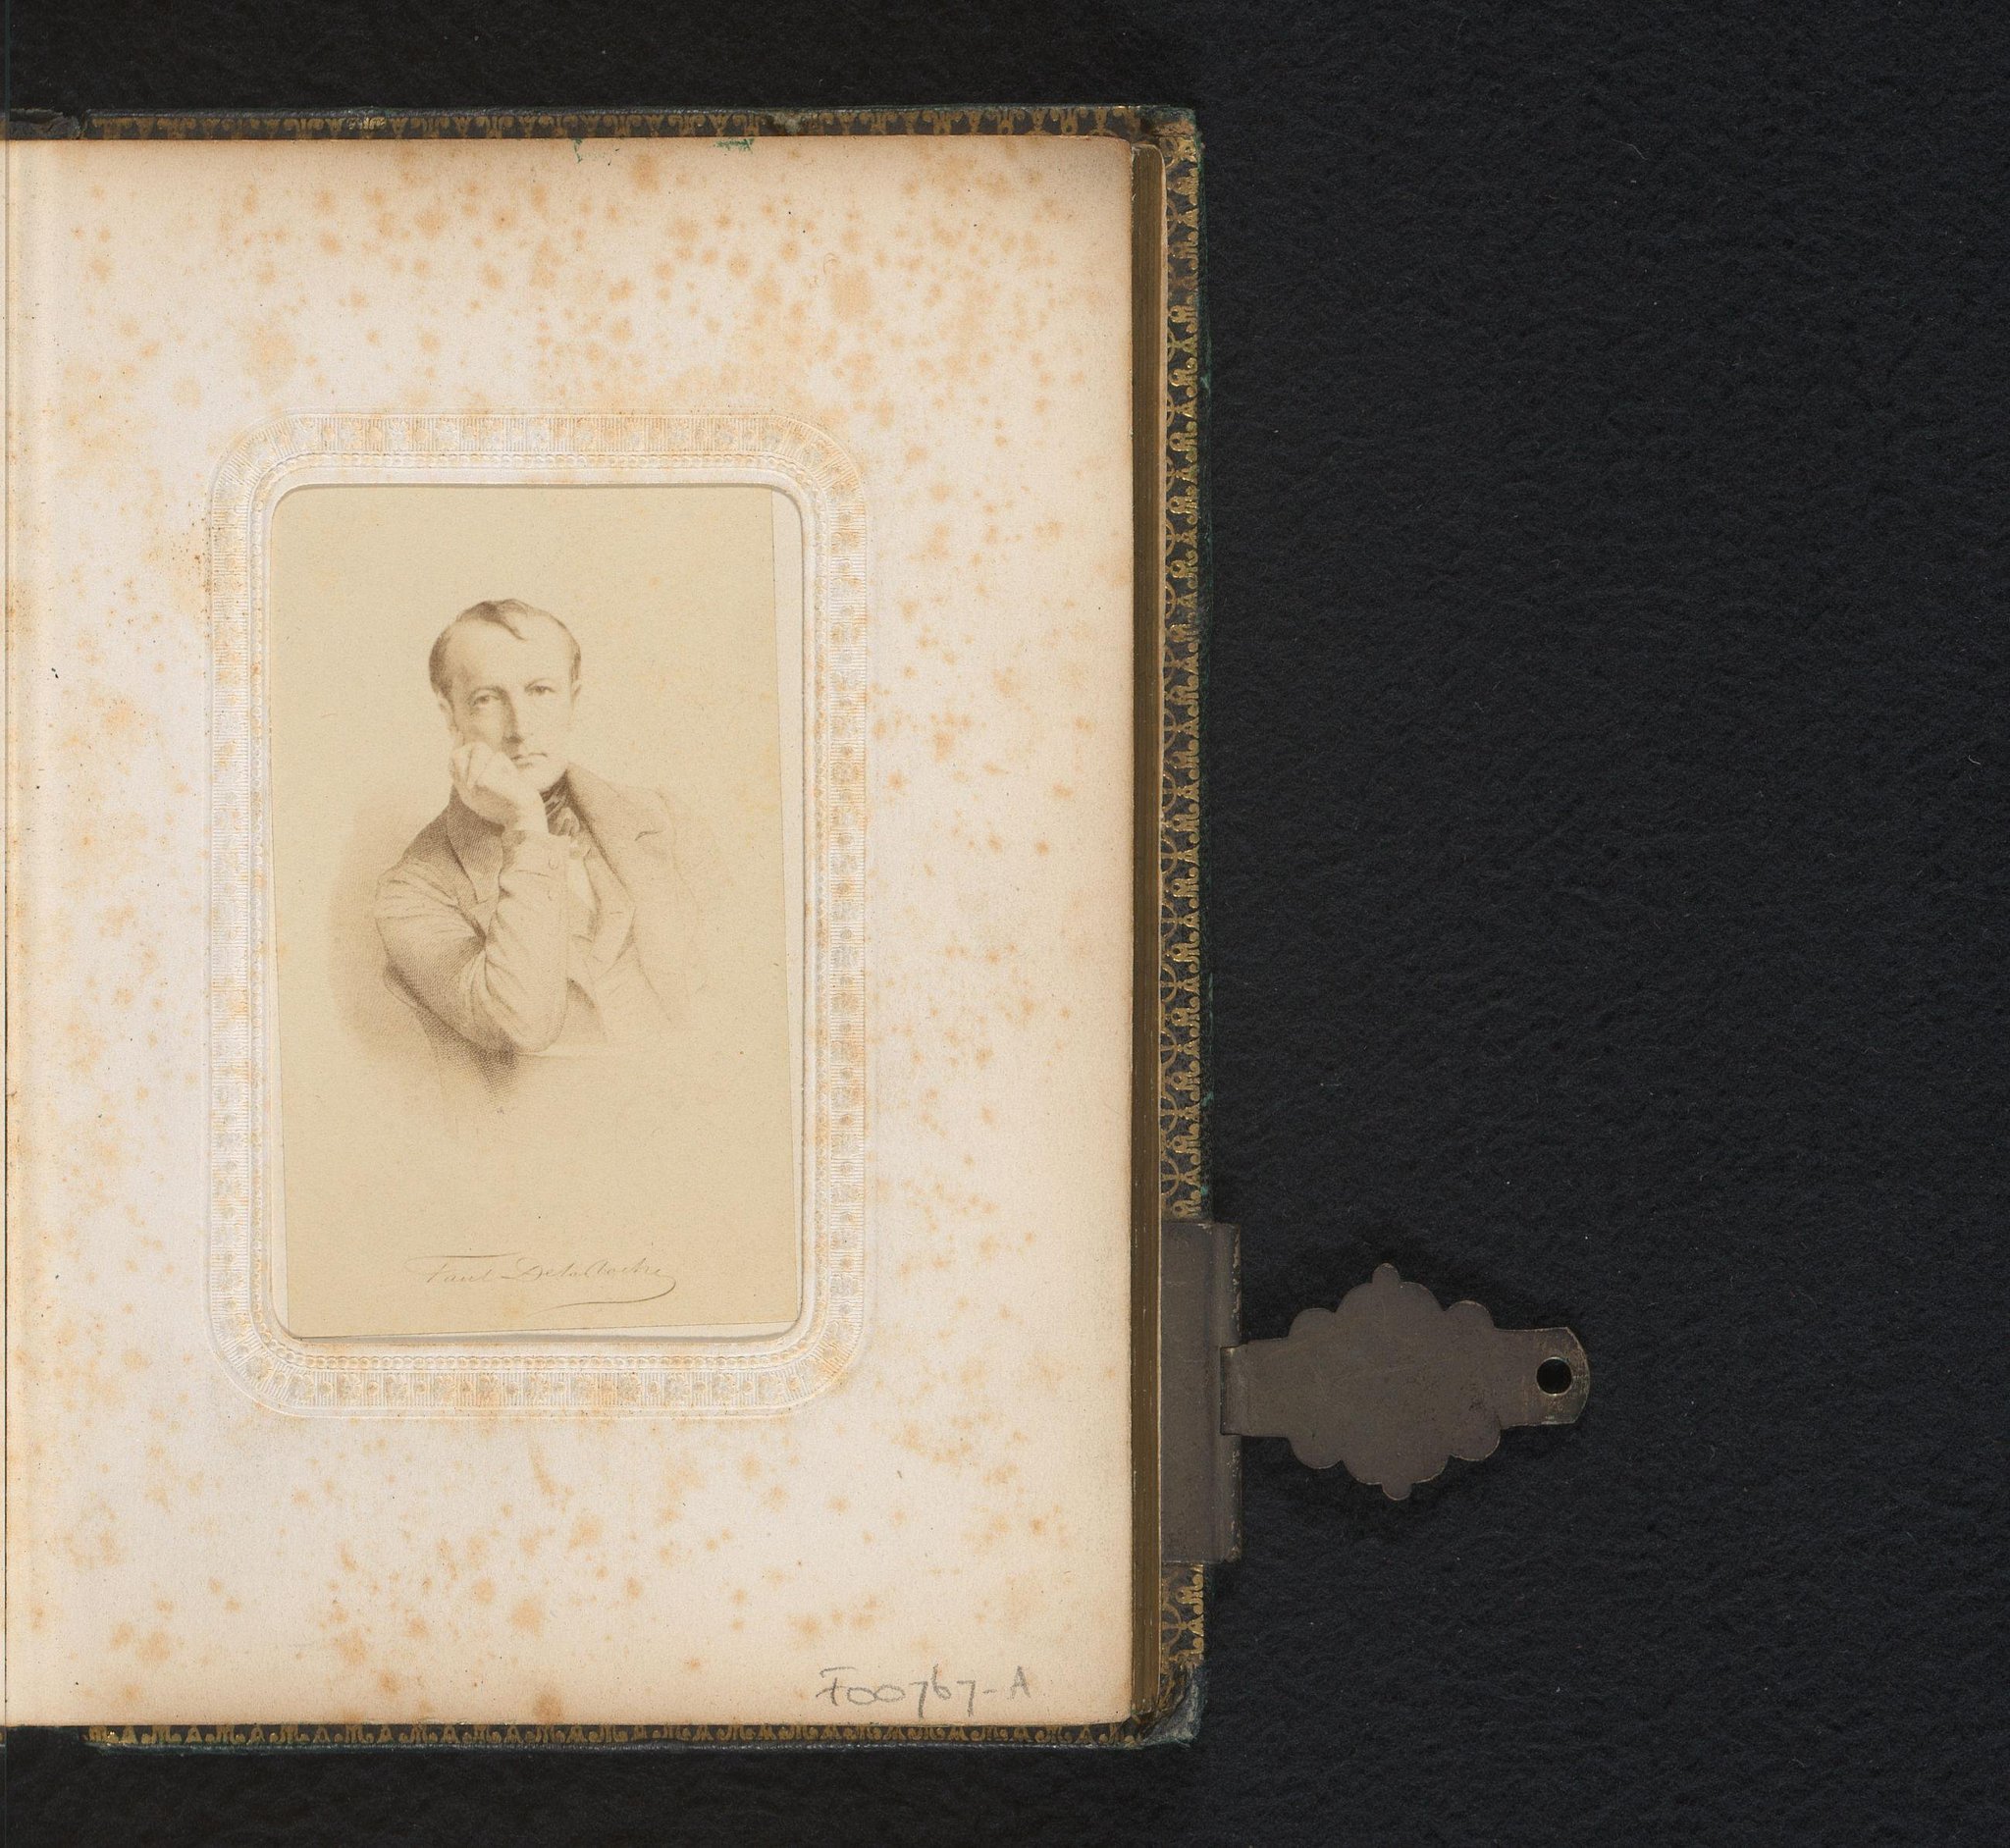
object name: photograph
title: Fotoreproductie van een getekend portret van Paul Delaroche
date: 1861-1878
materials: cardboard, photographic support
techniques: albumen print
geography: paris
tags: painter, draughtsman, sculptor, paul delaroche, historical persons, portrait, self-portrait of painter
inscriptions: inscription: ‘PHOTOGRAPHIE GOUPIL & Cie/ PARIS, 19, Bd Montmartre./ LONDRES-LA HAYE-BERLIN-NEW YORK.’